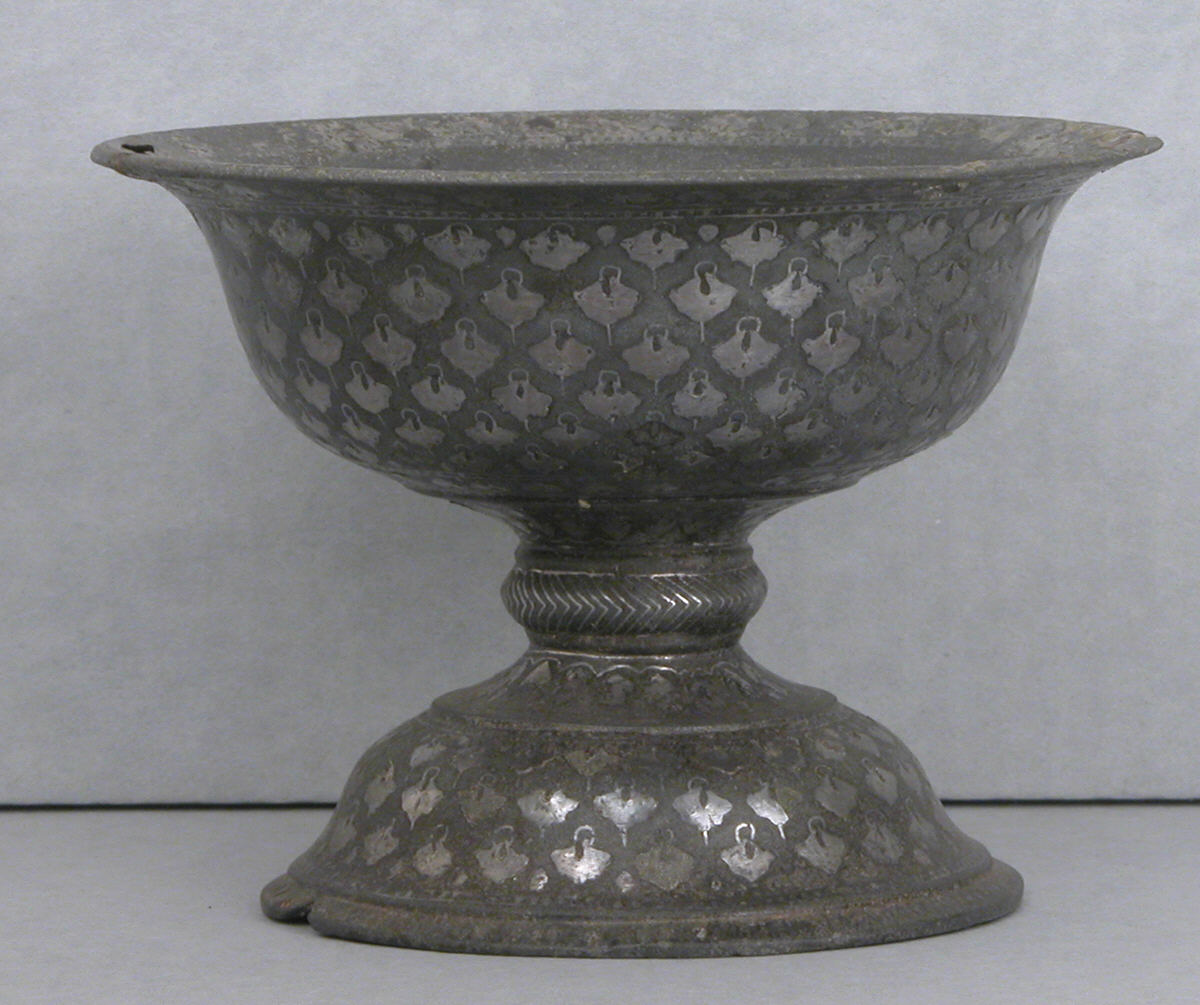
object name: spittoon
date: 1801-1833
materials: alloy, silver, zinc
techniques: casting, engraving, inlay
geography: india